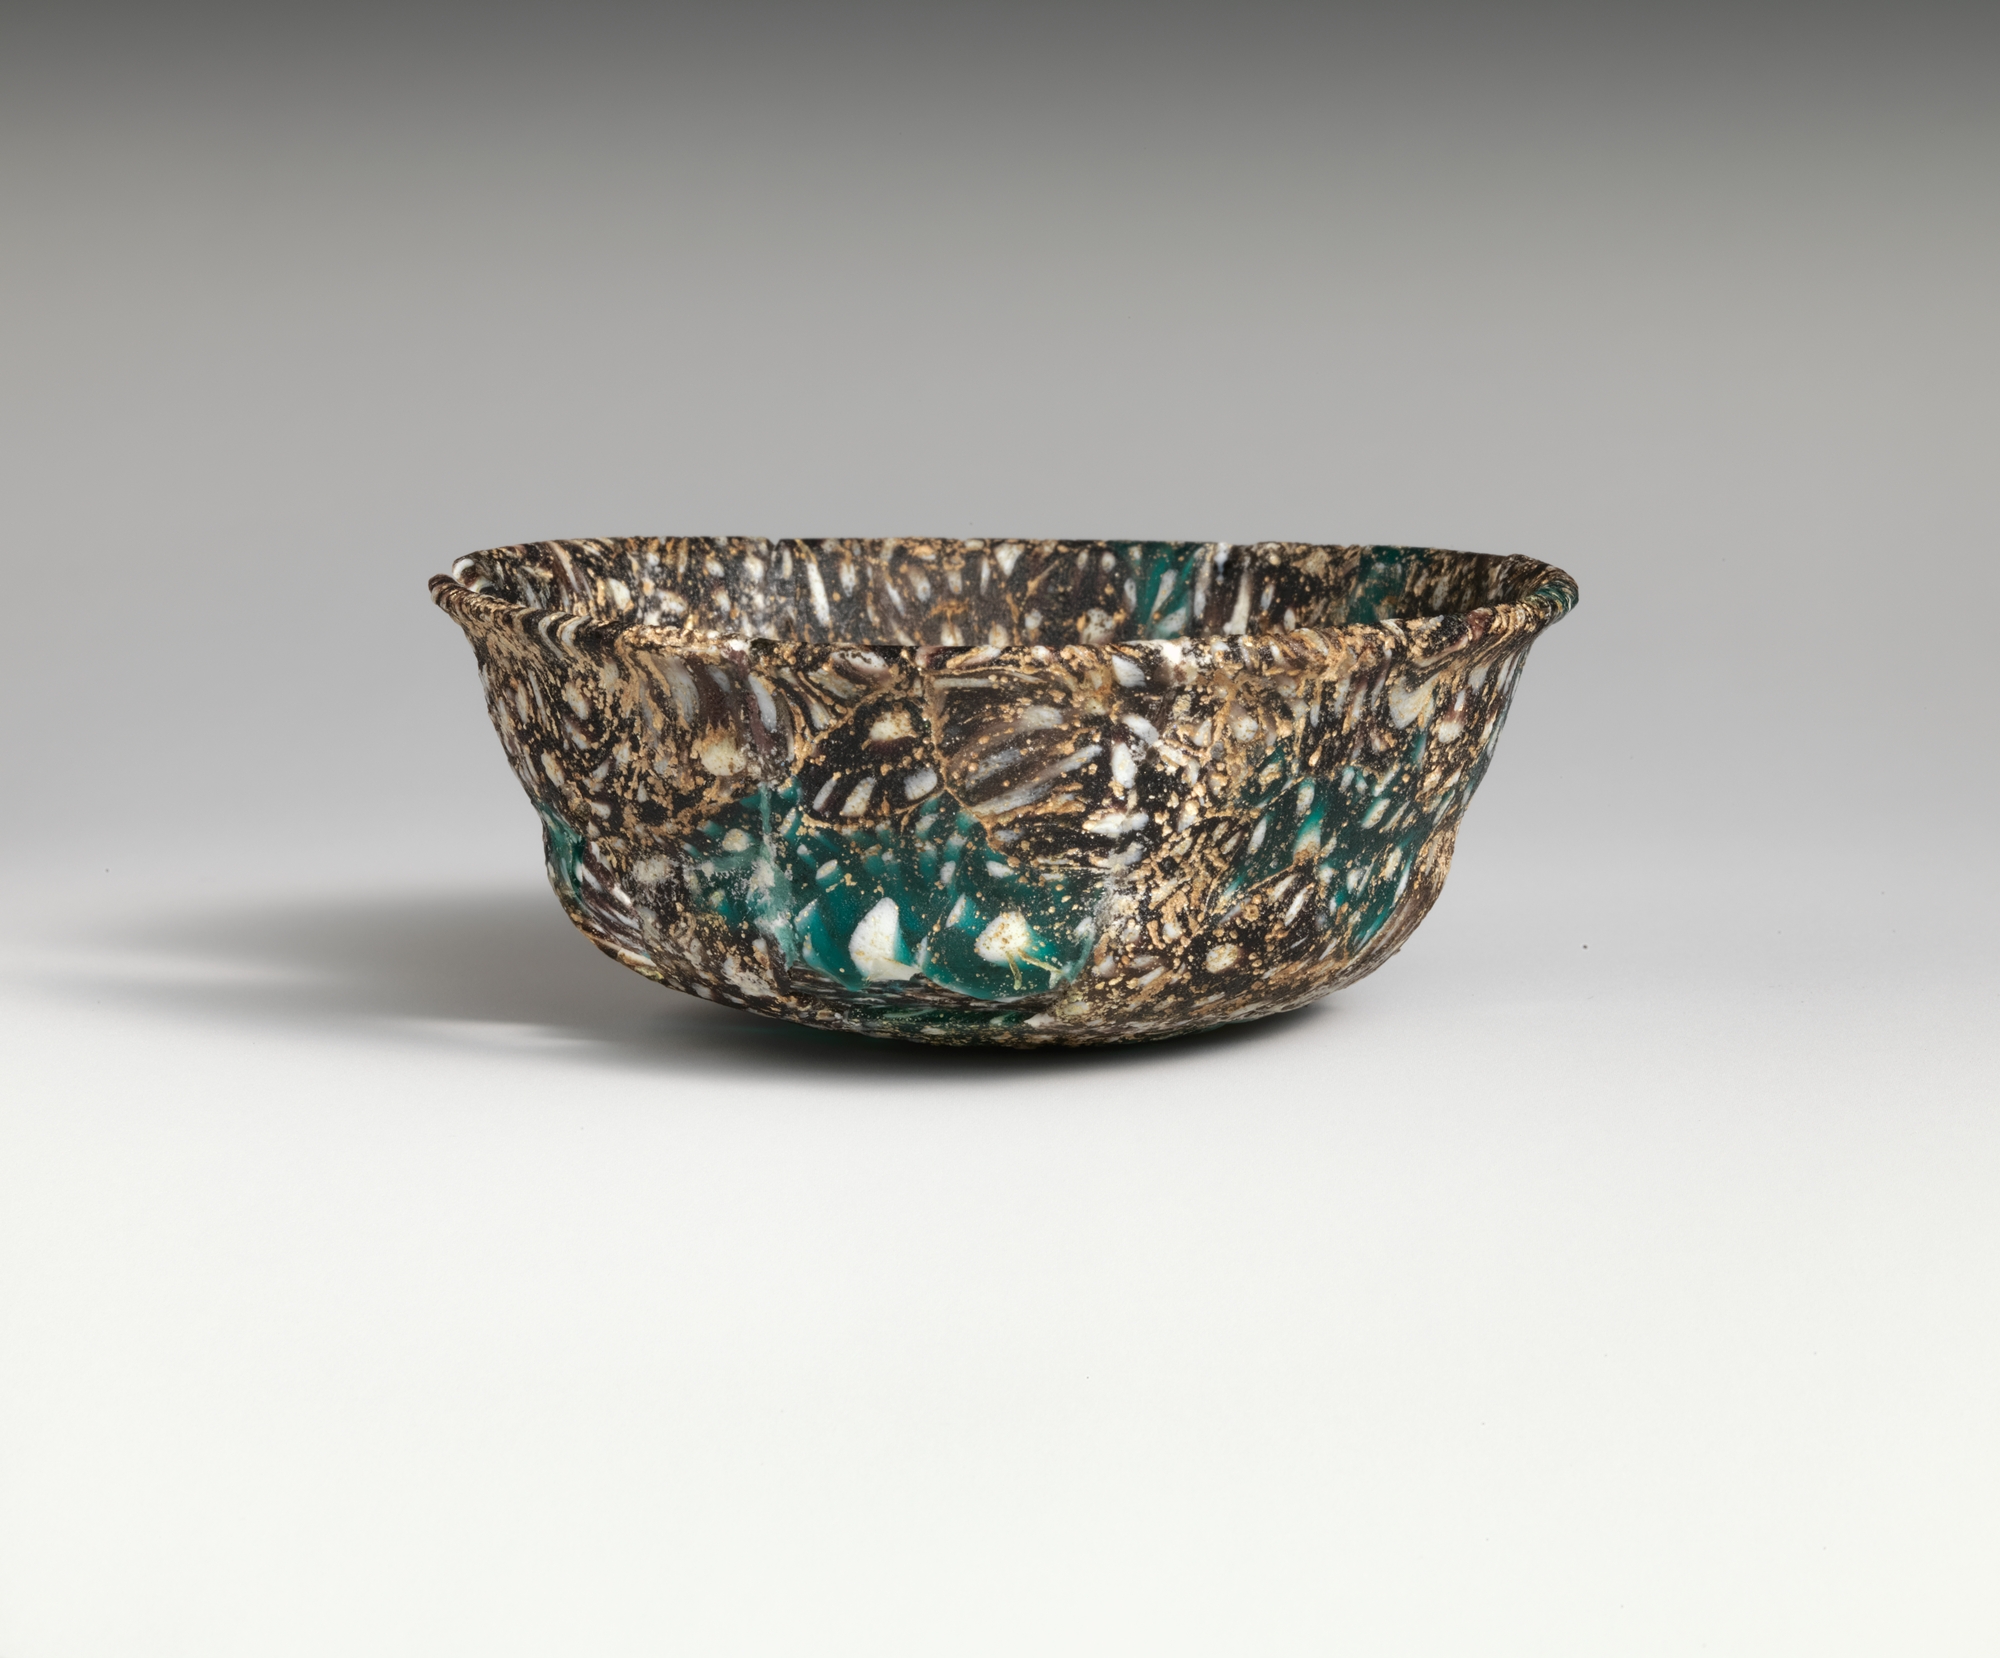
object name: bowl, mosaic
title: Mosaic glass bowl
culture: roman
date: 34 BCE-33 CE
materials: glass